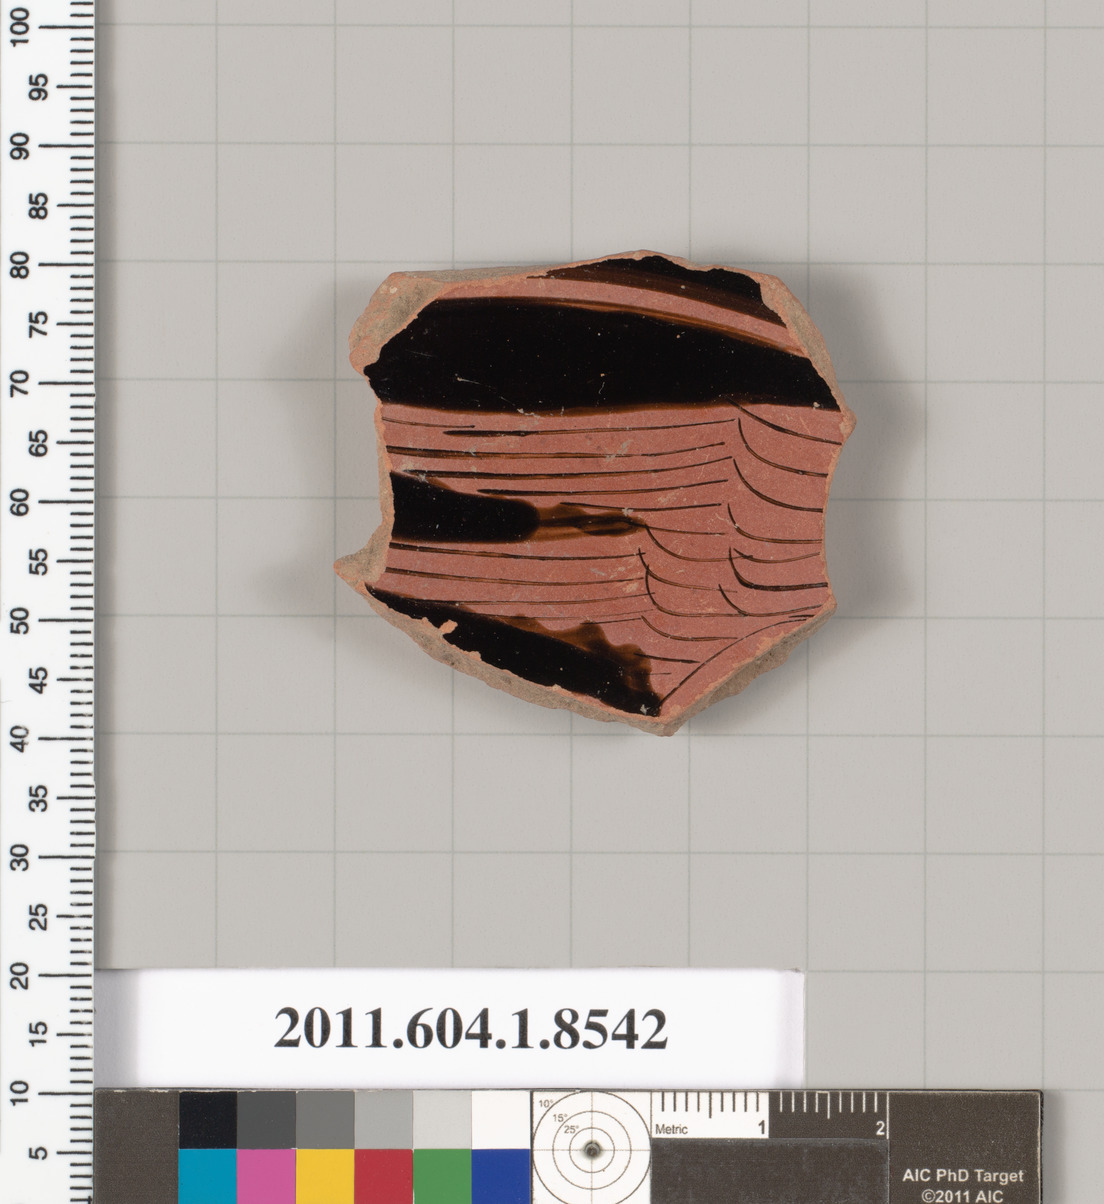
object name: kylix fragment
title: Terracotta fragment of a stemless kylix (drinking cup)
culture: greek, attic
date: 467-435 BCE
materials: terracotta